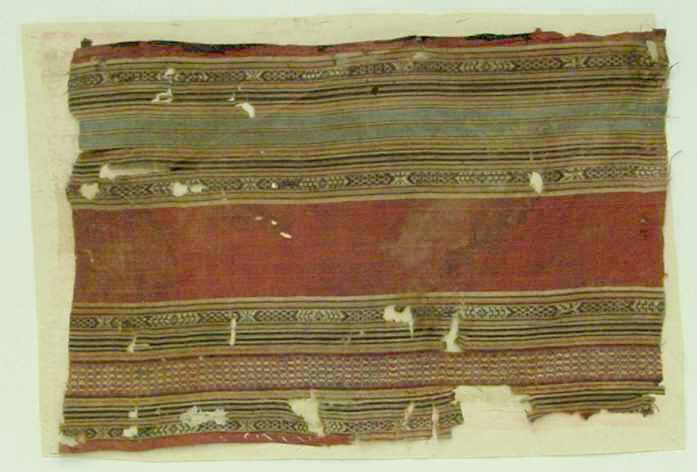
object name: textile fragment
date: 1201-1300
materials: silk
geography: egypt